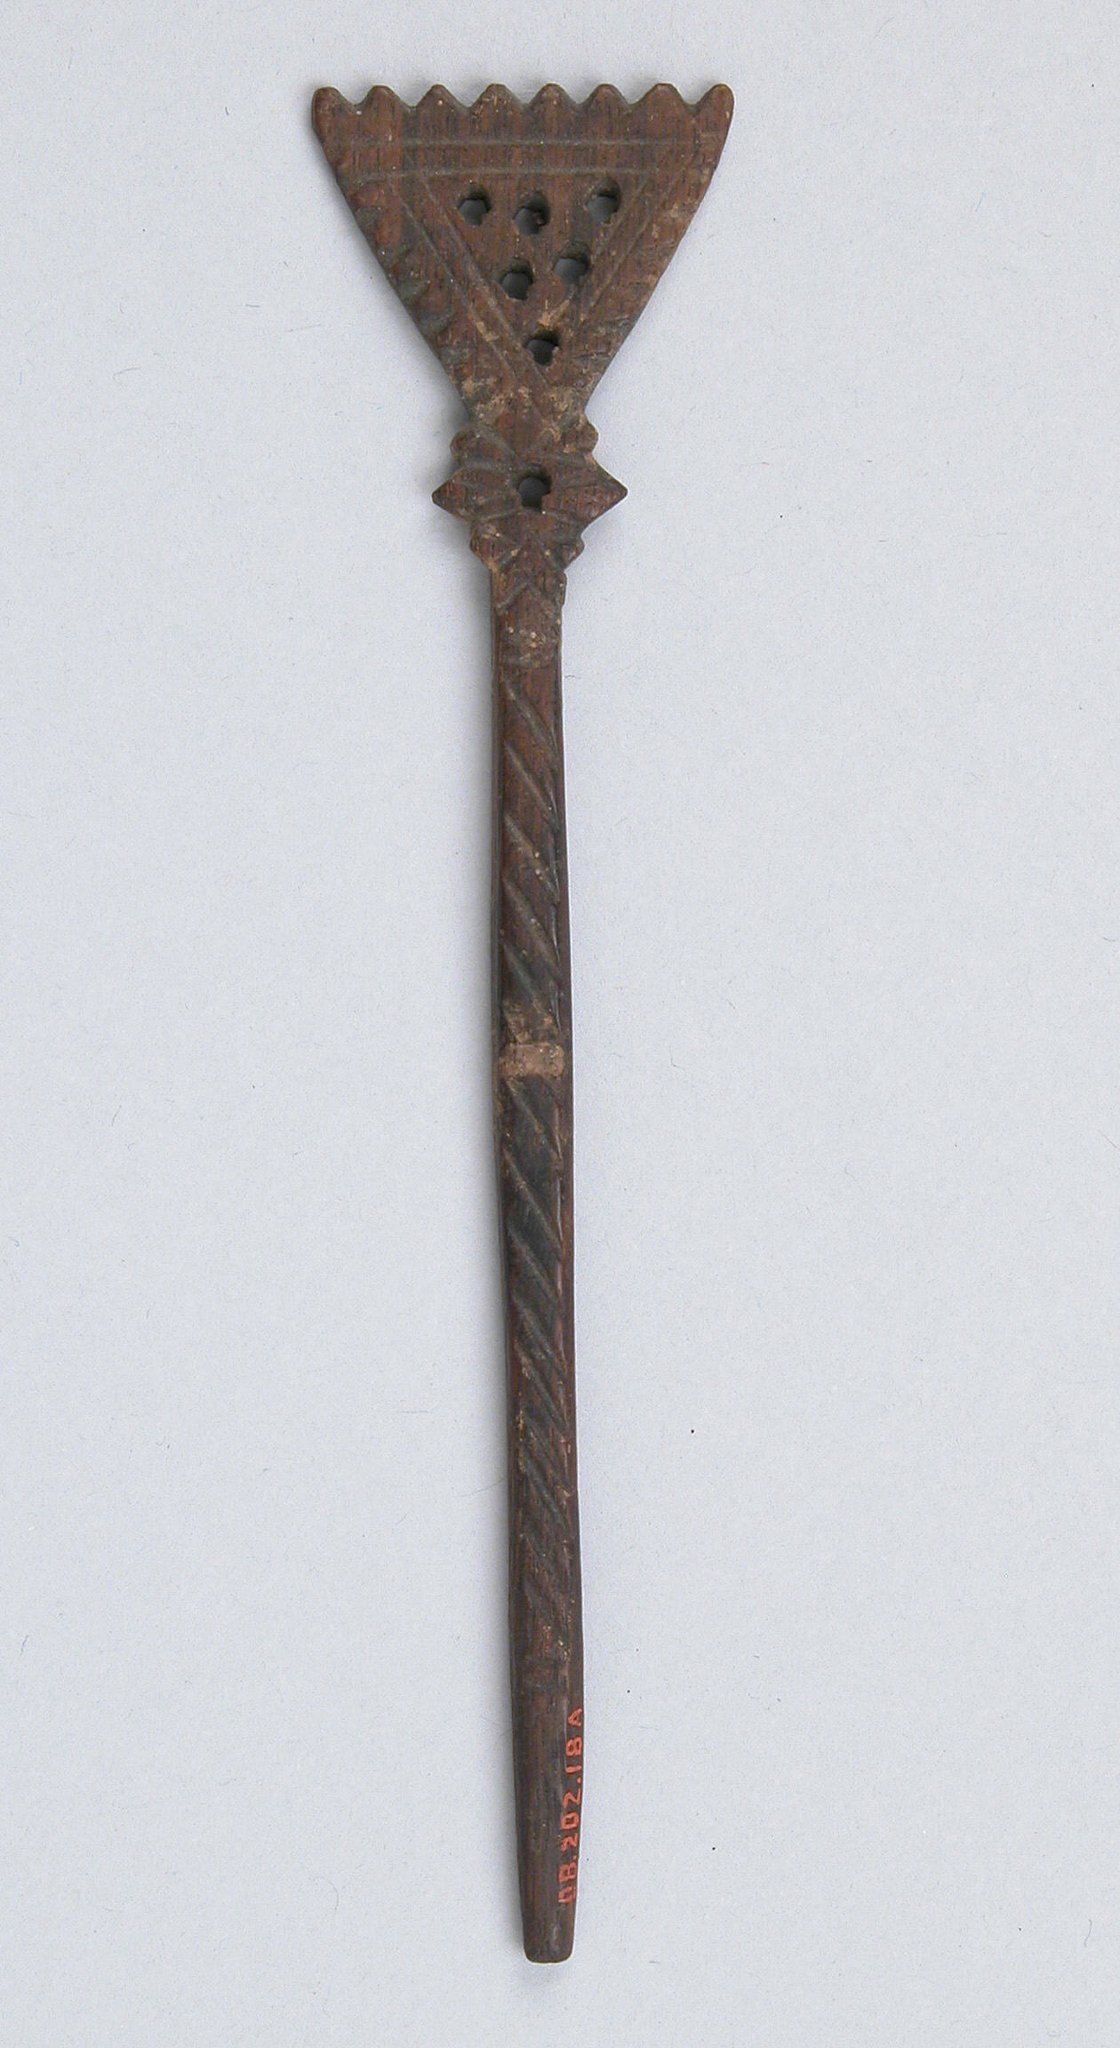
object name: hairpin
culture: coptic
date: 401-600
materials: wood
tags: pins